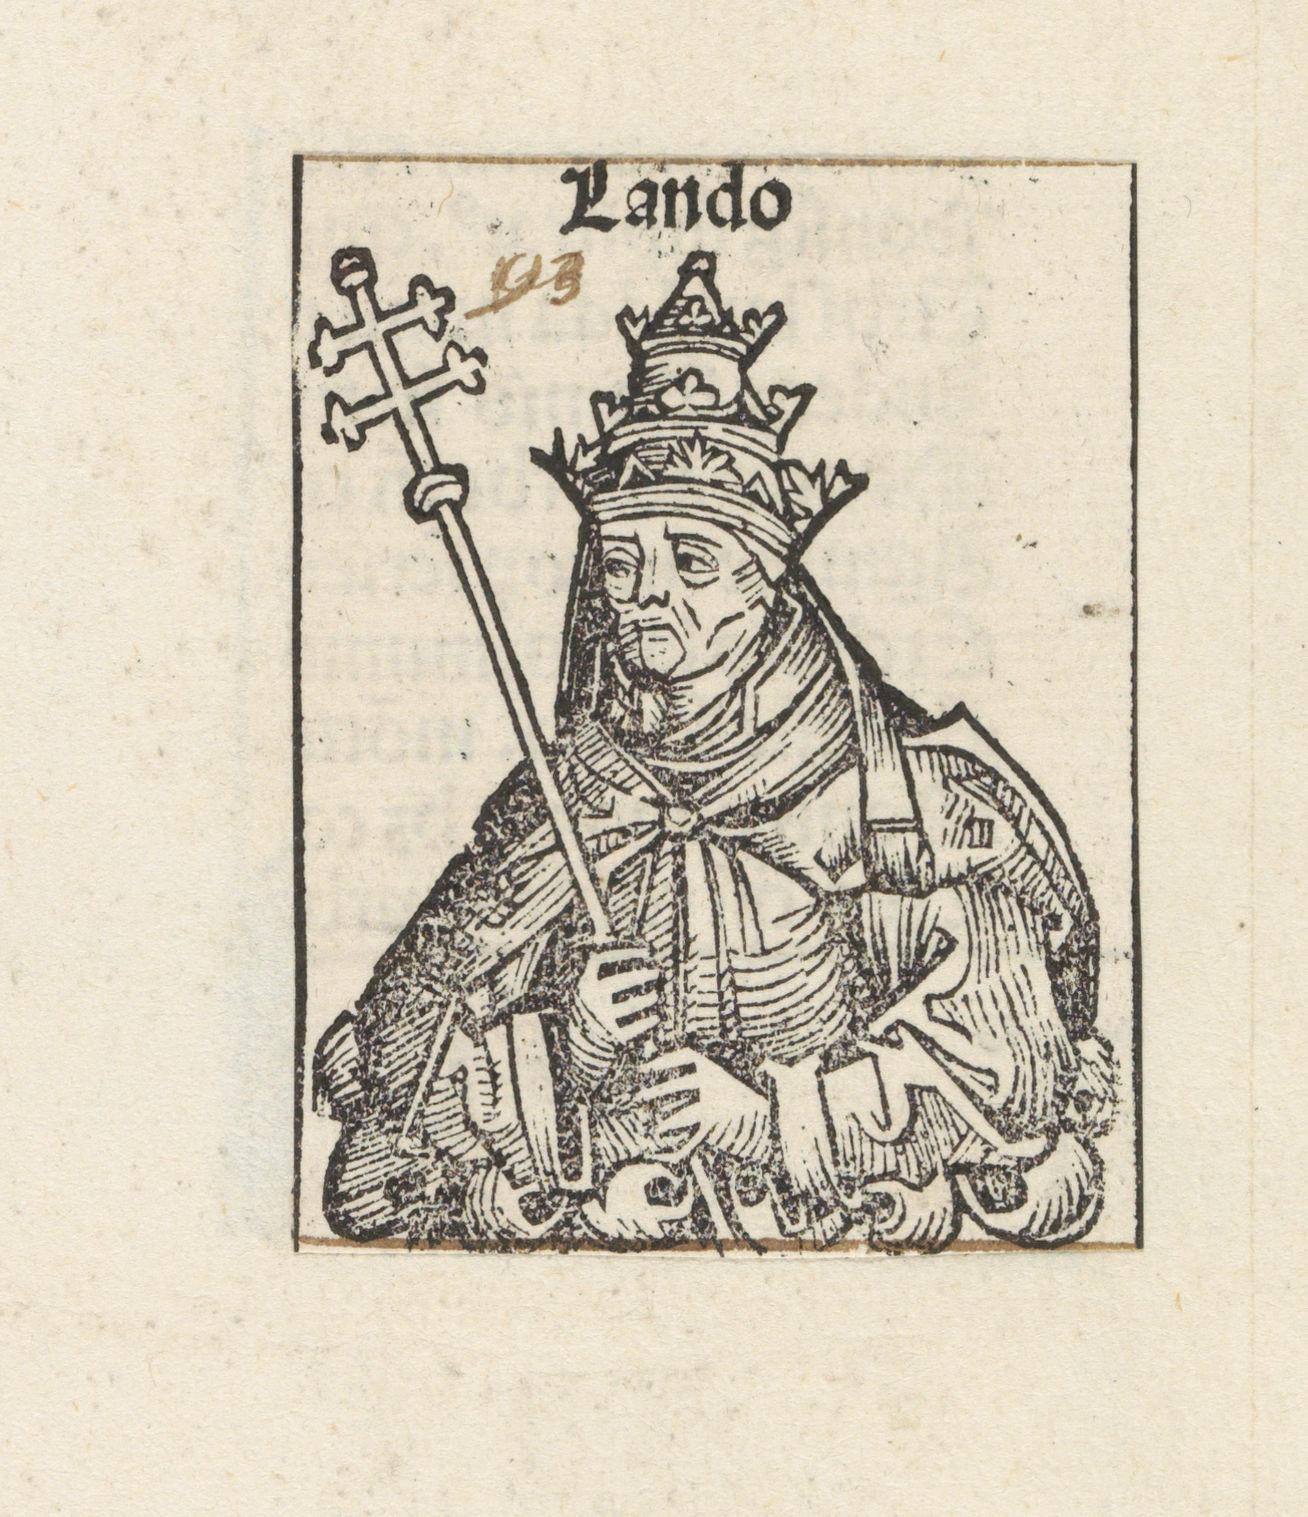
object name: print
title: Lando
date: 1493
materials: paper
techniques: letterpress printing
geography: nuremberg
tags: rome, pope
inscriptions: inscription: ‘93’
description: Een bloemkelk met een paus. Hij draagt een tiara en heeft een boek en een staf met een dubbel kruis in zijn handen. De voorstelling is onderdeel van de opeenvolging pausen in de Liber Chronicarum. De tekst identificeert de man als Lando. De prent maakt deel uit van een album.